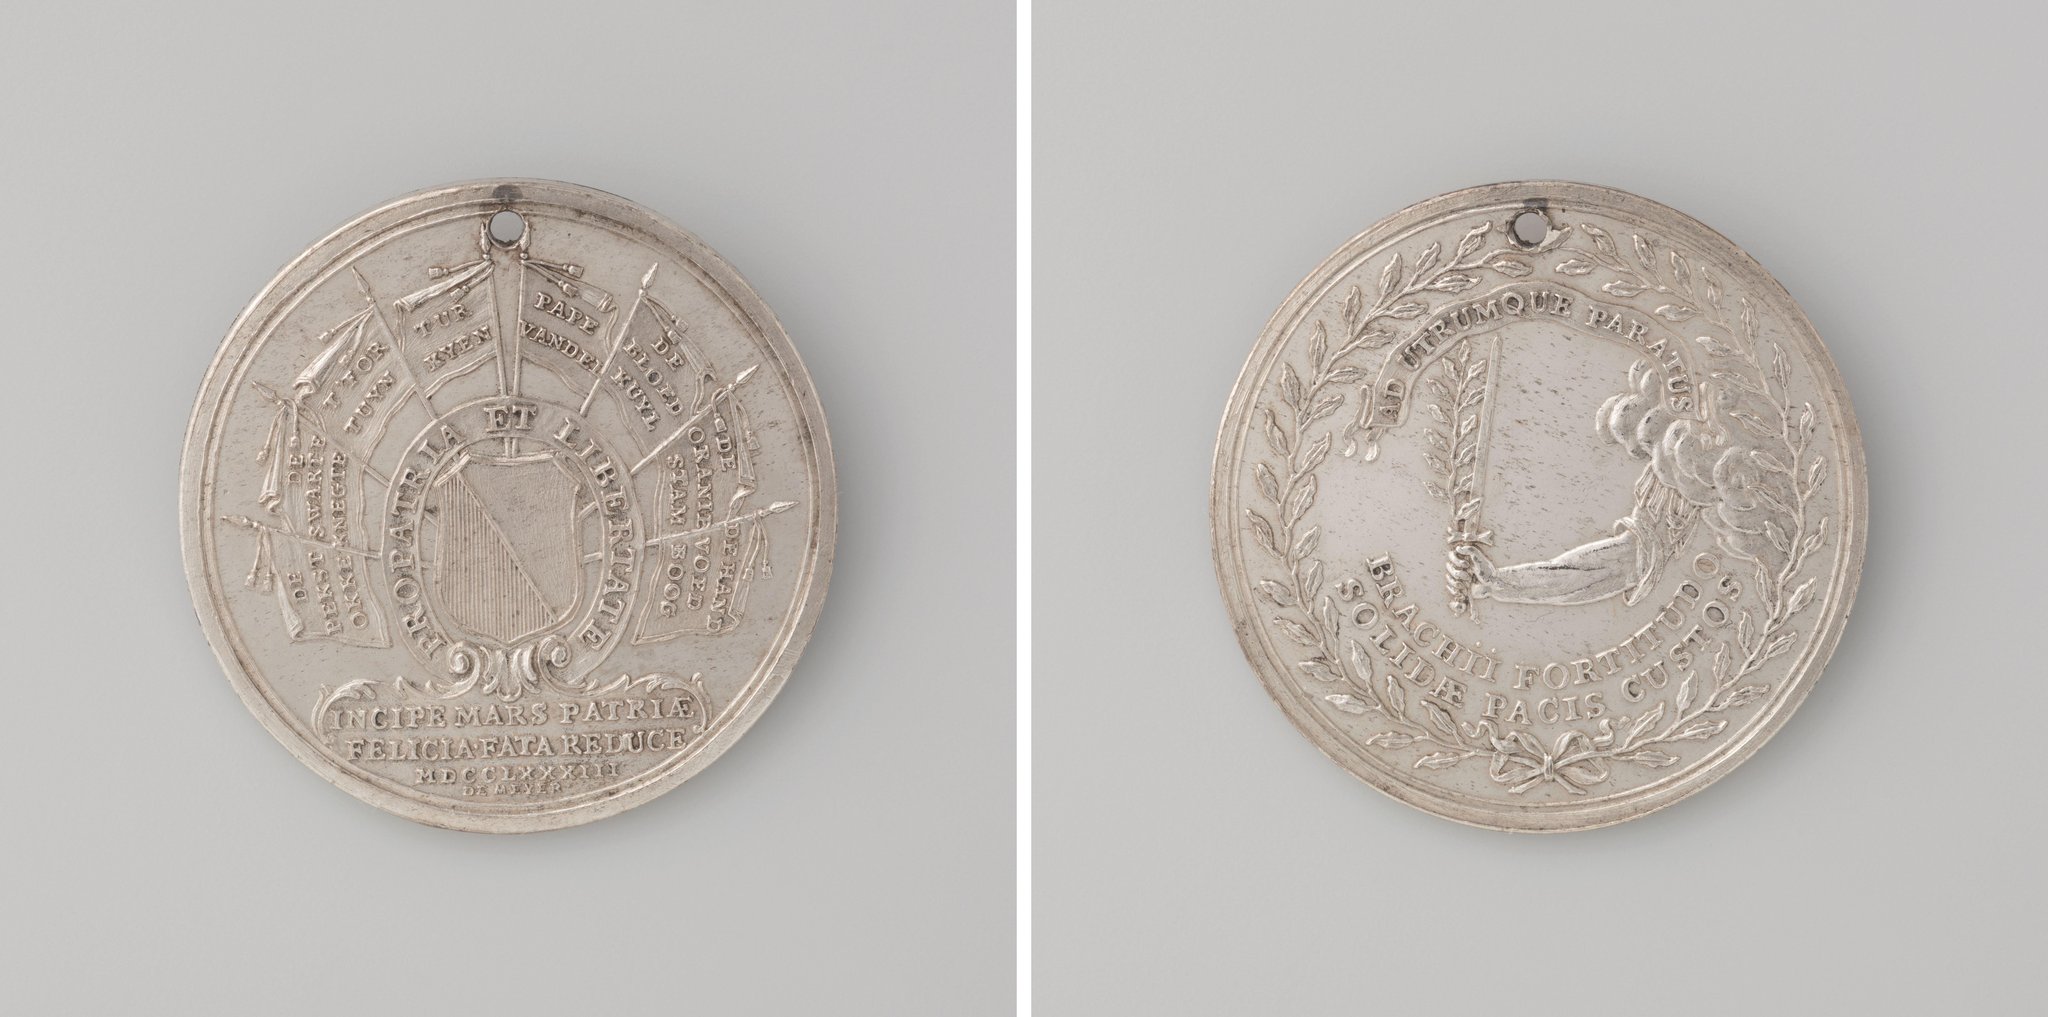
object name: history medal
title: Utrechts wapengenootschap Pro Patria et Libertate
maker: hendrik de meijer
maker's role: die cutter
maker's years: 1766-1789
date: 1783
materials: silver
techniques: striking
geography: utrecht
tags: utrecht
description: Zilveren penning met gat erin. Voorzijde: wapenschild, omgeven door wimpel met opschriften en standaards van de acht burgercompagnieen boven cartouche met opschrift. Keerzijde: arm uit wolken met zwaard en olijftak onder wimpel met opschrift en boven tweeregelig opschrift binnen lauwerkrans